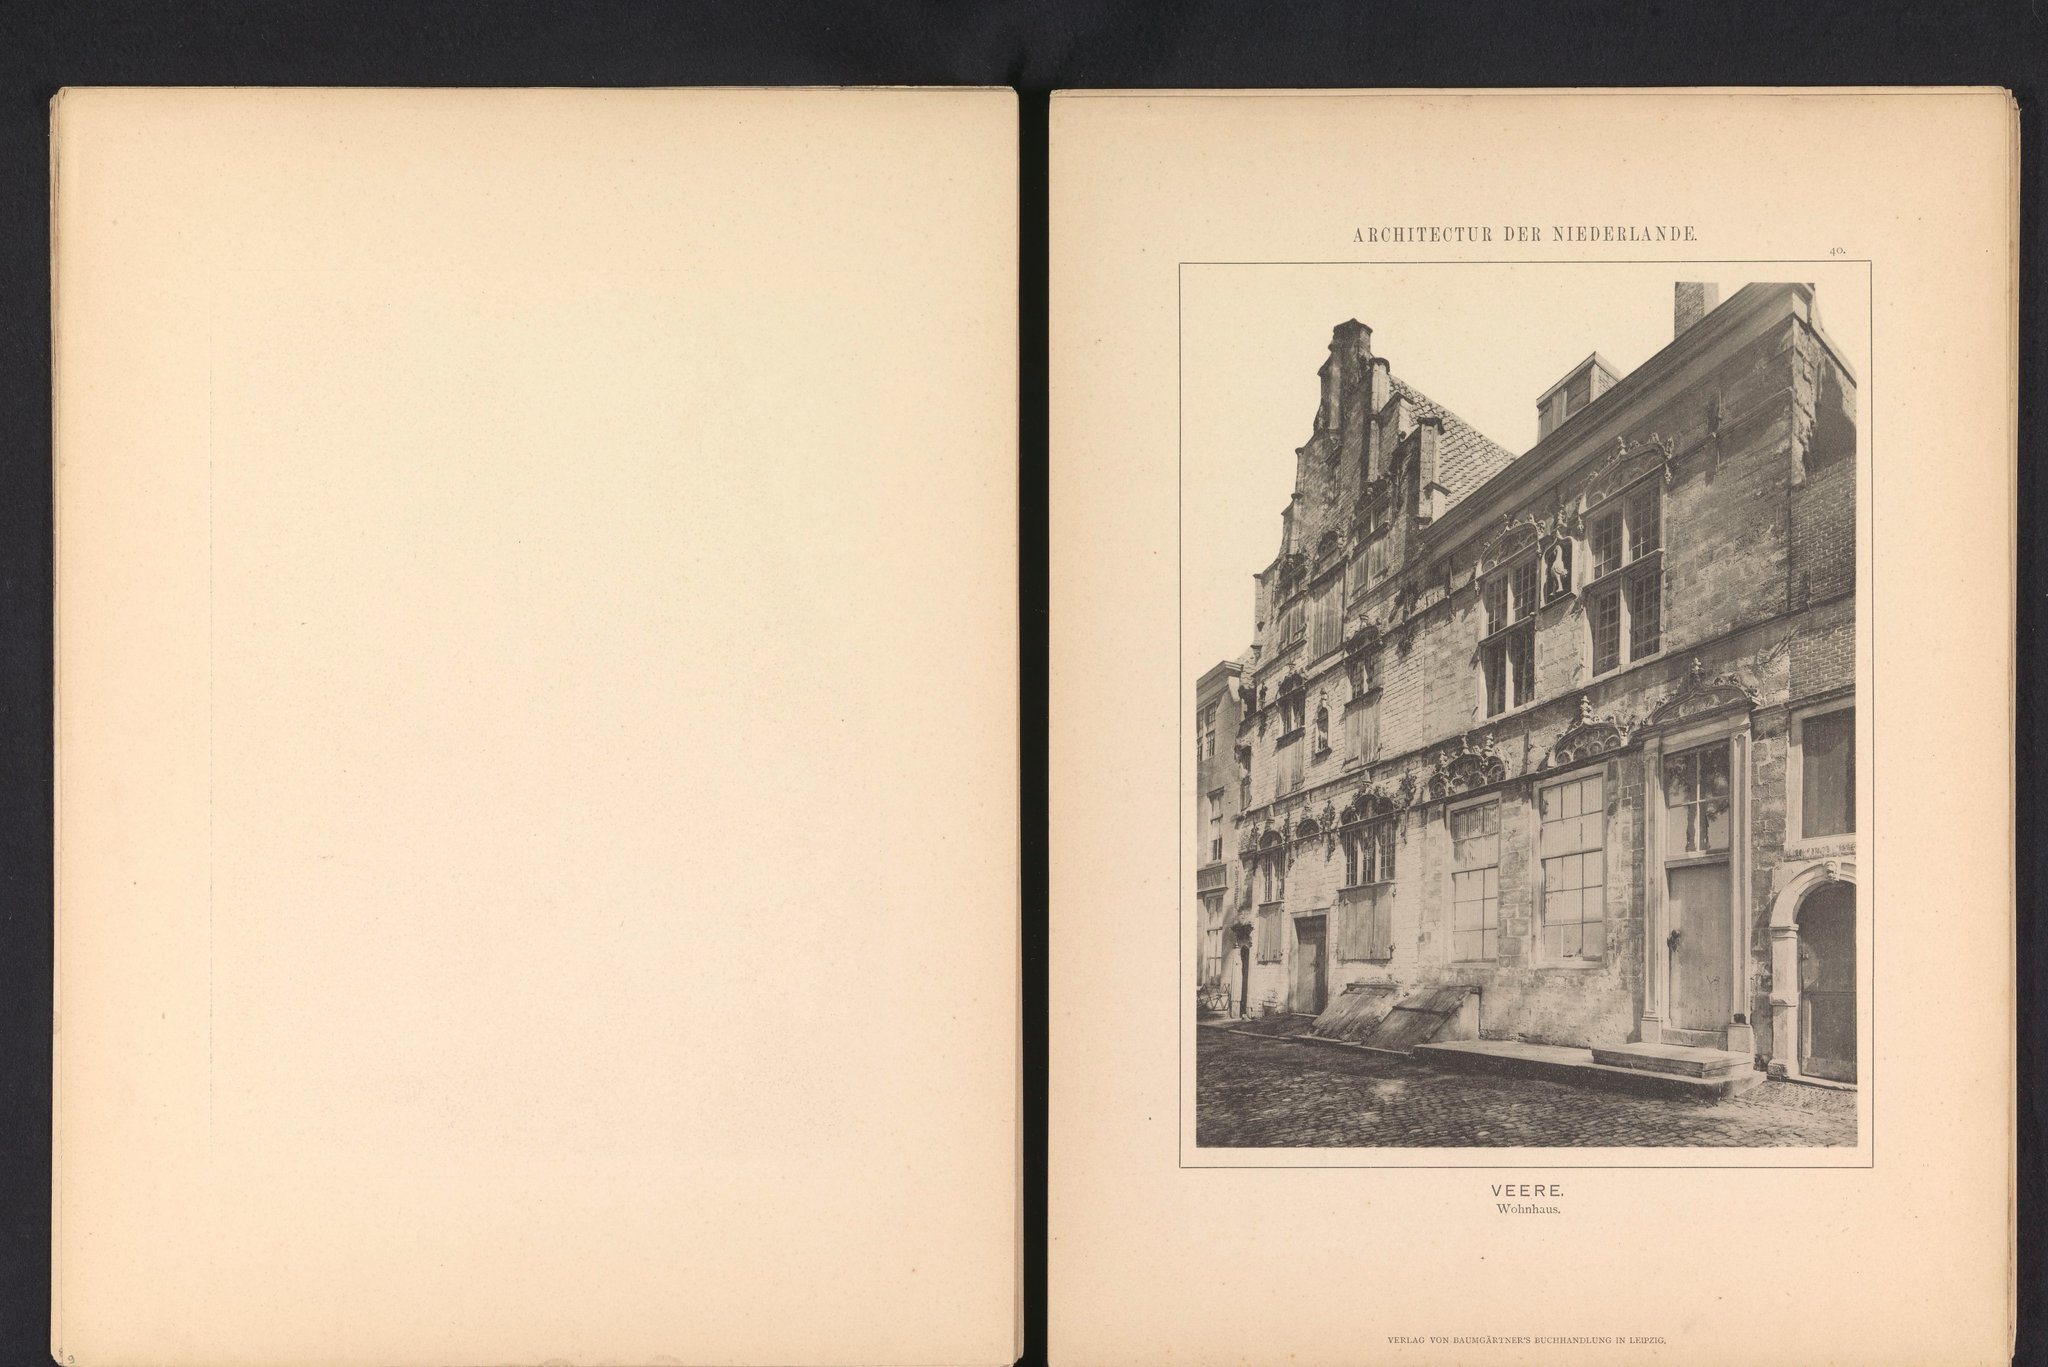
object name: photomechanical print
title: Architectur der Niederlande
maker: Anonymous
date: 1884-1894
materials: paper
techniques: photograph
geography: leipzig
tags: decorated gable, stone tablet in façade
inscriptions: number: ‘40.’